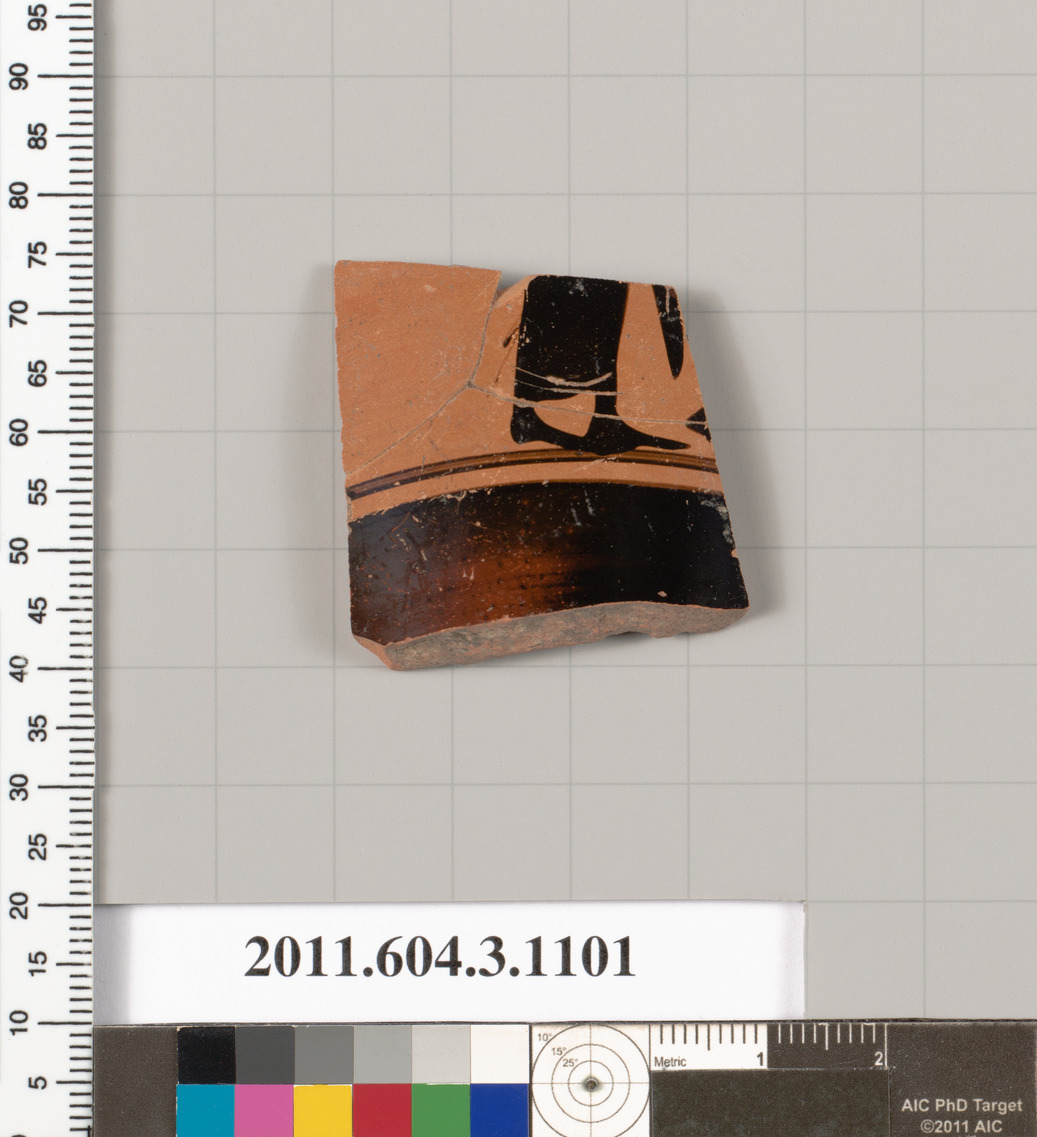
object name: mastoid or kyathos fragment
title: Terracotta fragment of a mastoid (drinking cup with narrow base) or a kyathos (cup-shaped ladle)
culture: greek, attic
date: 534-468 BCE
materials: terracotta